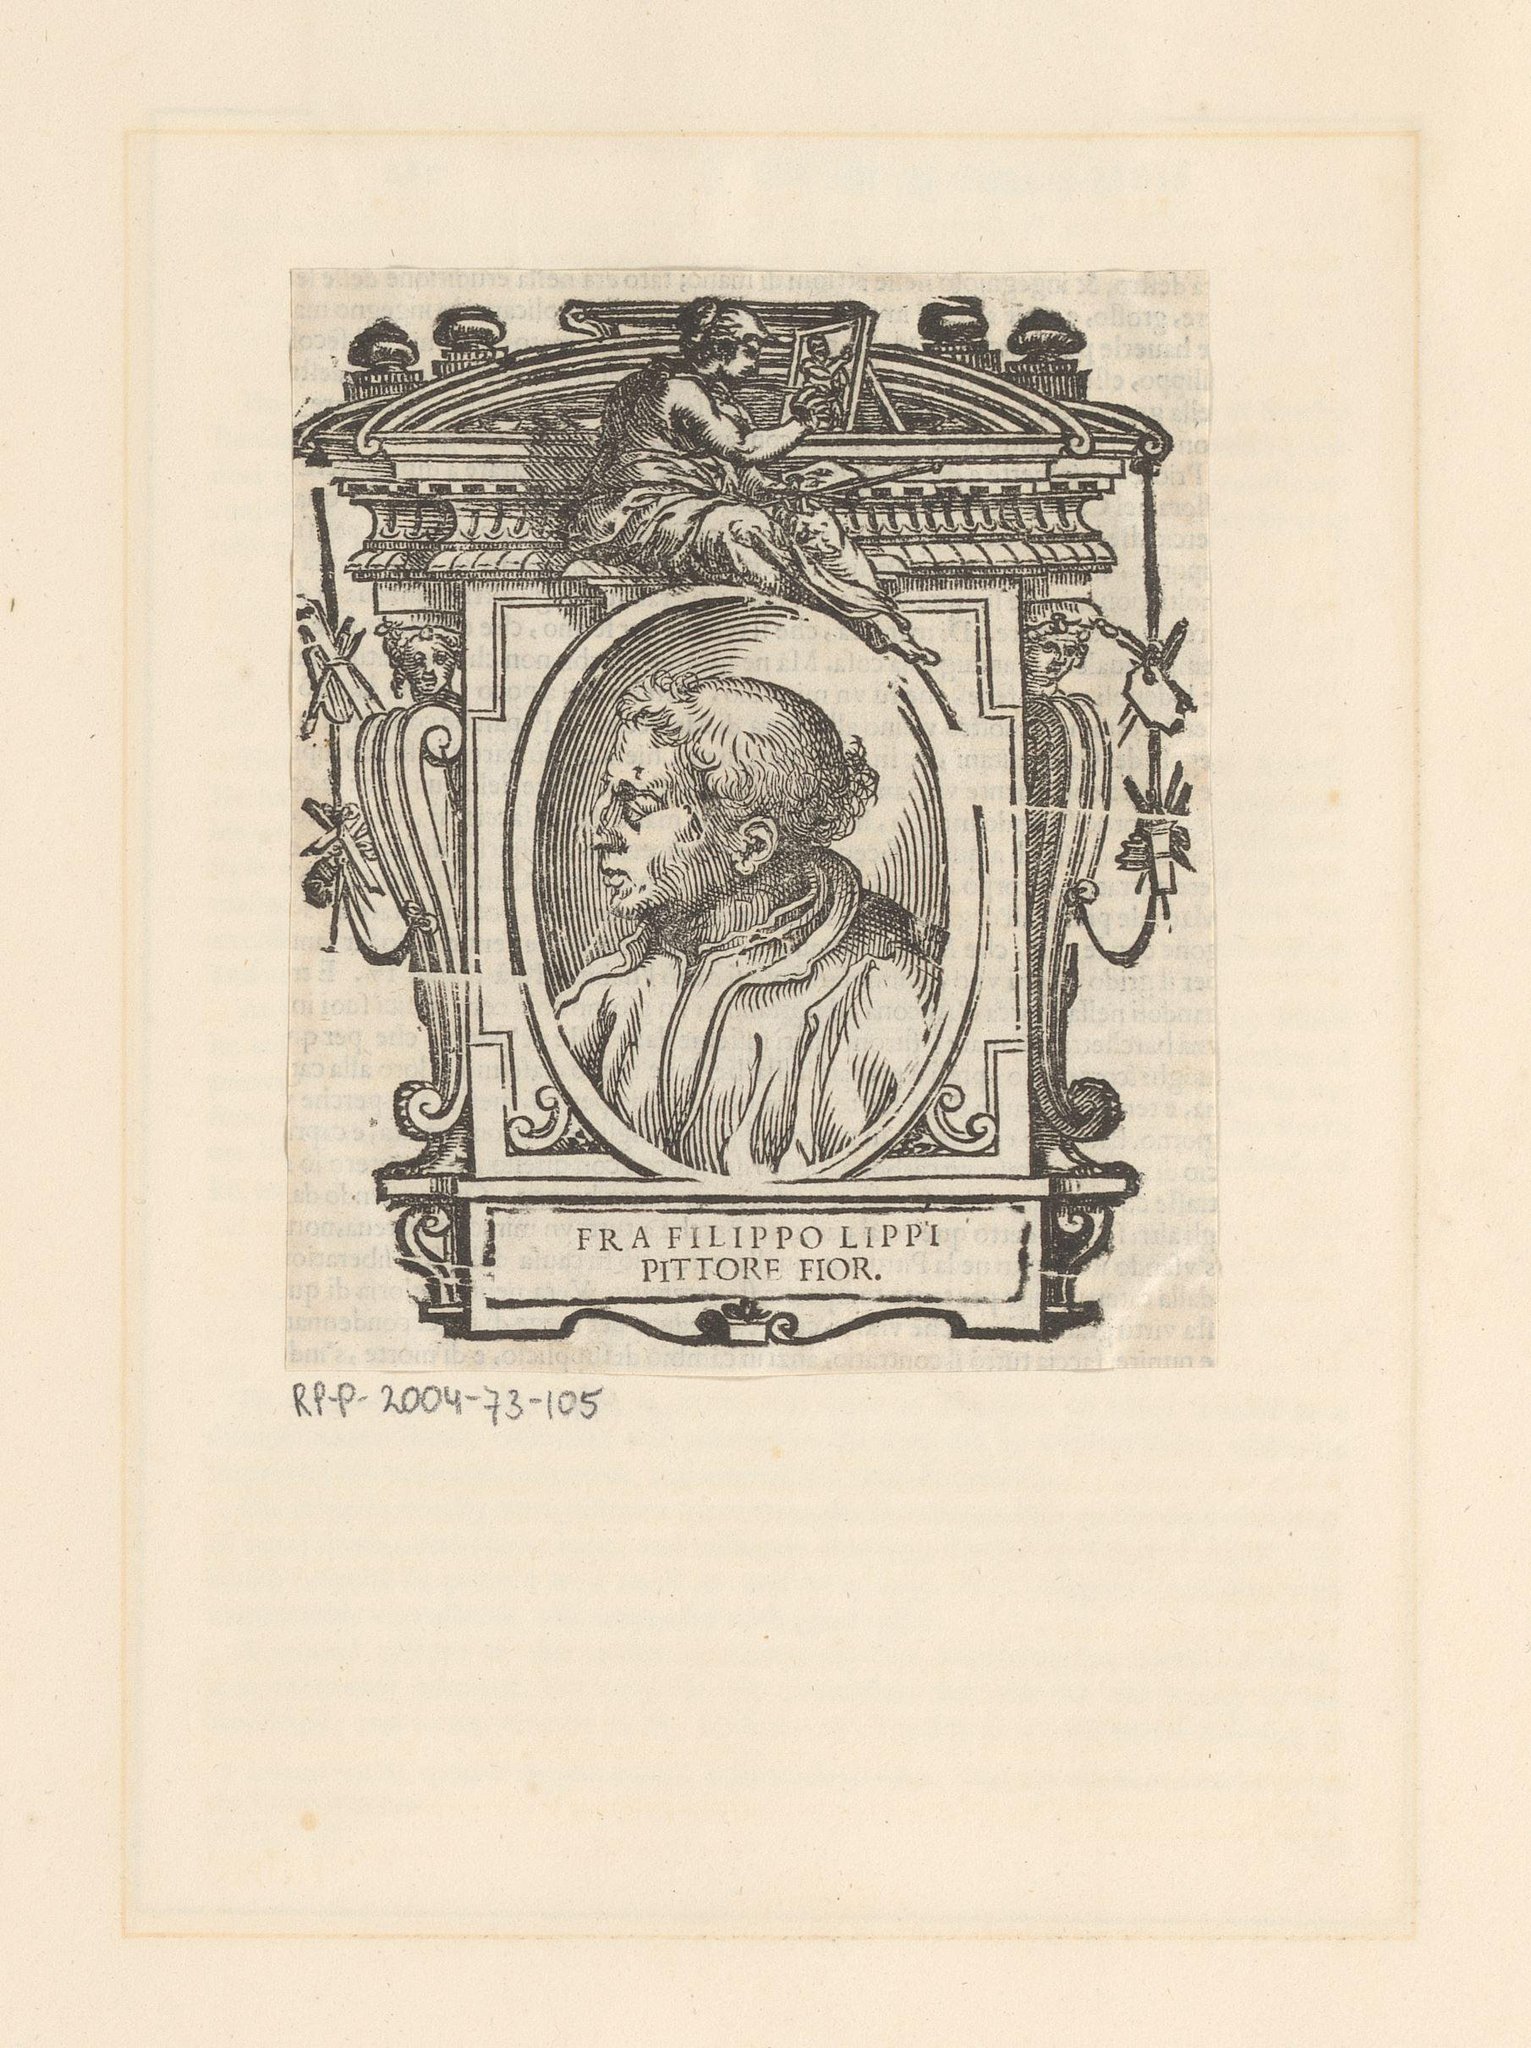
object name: album leaf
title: Fra Filippo Lippi Pittore Fior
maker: Anonymous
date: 1568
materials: paper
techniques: letterpress printing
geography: florence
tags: painter, filippo lippi, historical persons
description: Eerdere staat van prent gebruikt in: Vasari, Giorgio. Le Vite de' più eccellenti pittori, scultori, e architettori da Cimabue insino a' tempi nostri. 4 dln. Florence: Giunti, 1568, dl. 1, p. 385. De samensteller heeft deze prent in het album geplakt als illustratie bij: Pilkington, Matthew en Johann Heinrich Füssli. A dictionary of painters, from the revival of the art to the present period. 4 dln. Londen: John Crowder, 1805, dl. 2, p. 300.